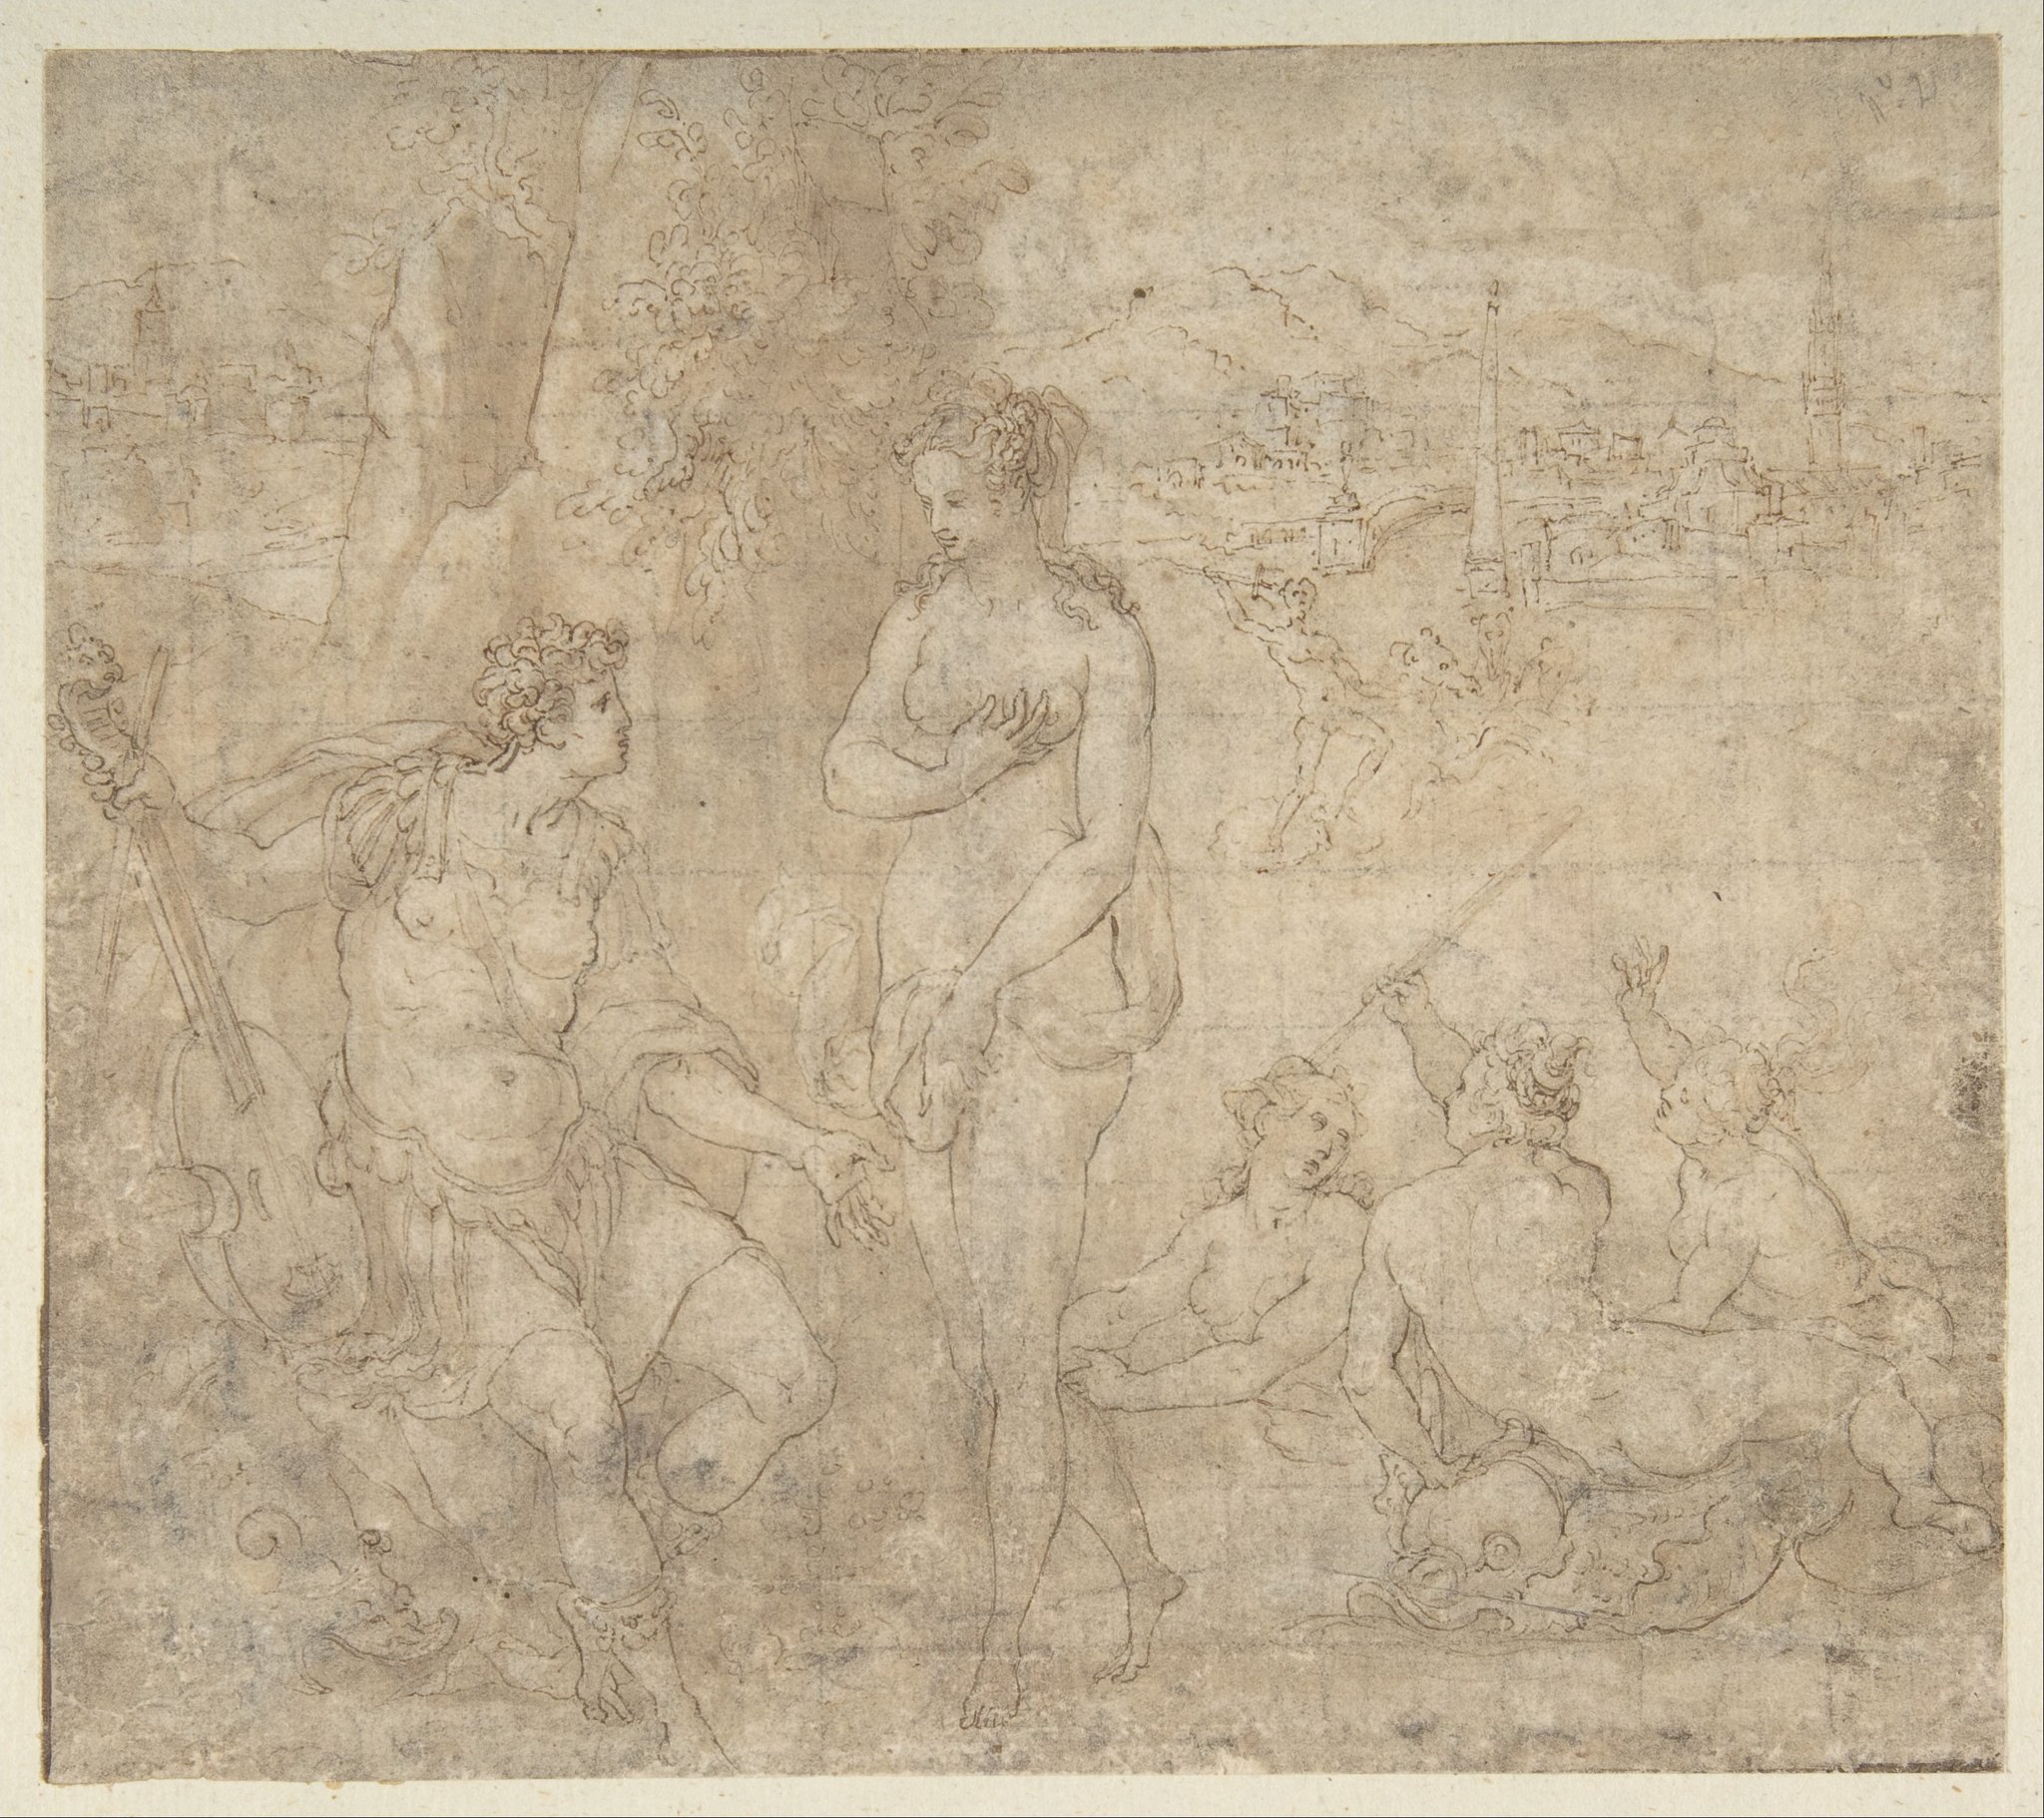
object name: drawing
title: Apollo and Galatea in a Landscape with Neptune and Three Nymphs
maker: orazio samacchini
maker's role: artist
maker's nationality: italian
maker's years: 1532-1577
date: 1550-1560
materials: chalk, ink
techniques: brush, pen, drawing, wash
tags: apollo,galatea,nymphs,neptune,landscapes